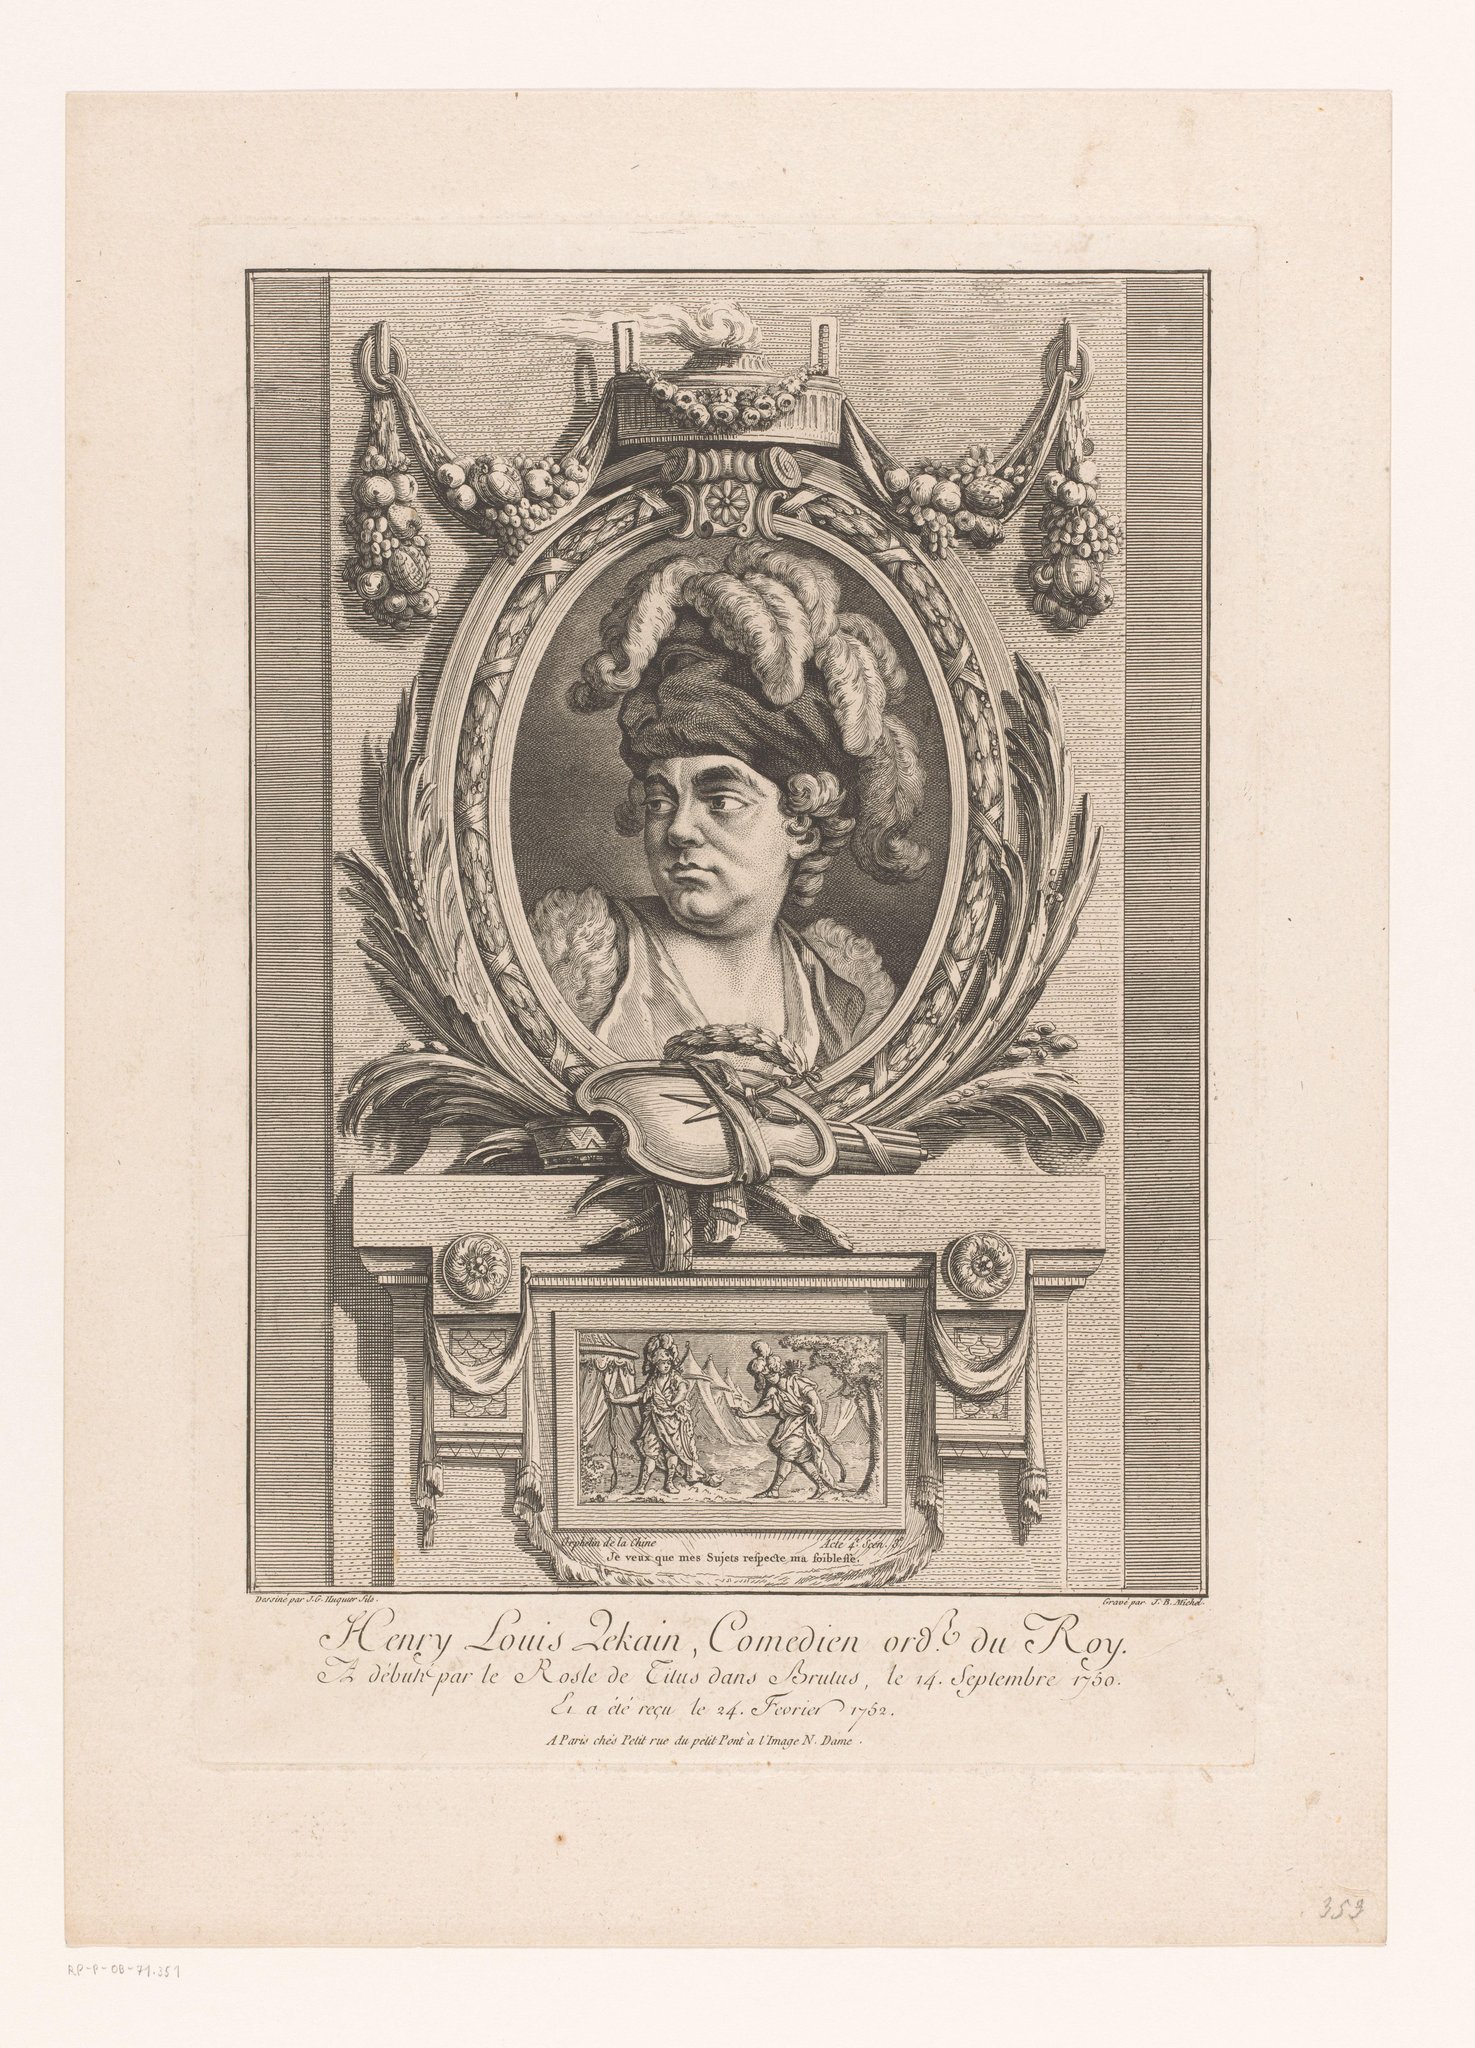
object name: print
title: Henry Louis Zekain, Comedien ord.e du Roi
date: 1758-1804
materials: paper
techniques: engraving, etching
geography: paris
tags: historical persons, portrait of actor, actress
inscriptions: collector's mark: Lugt 2228